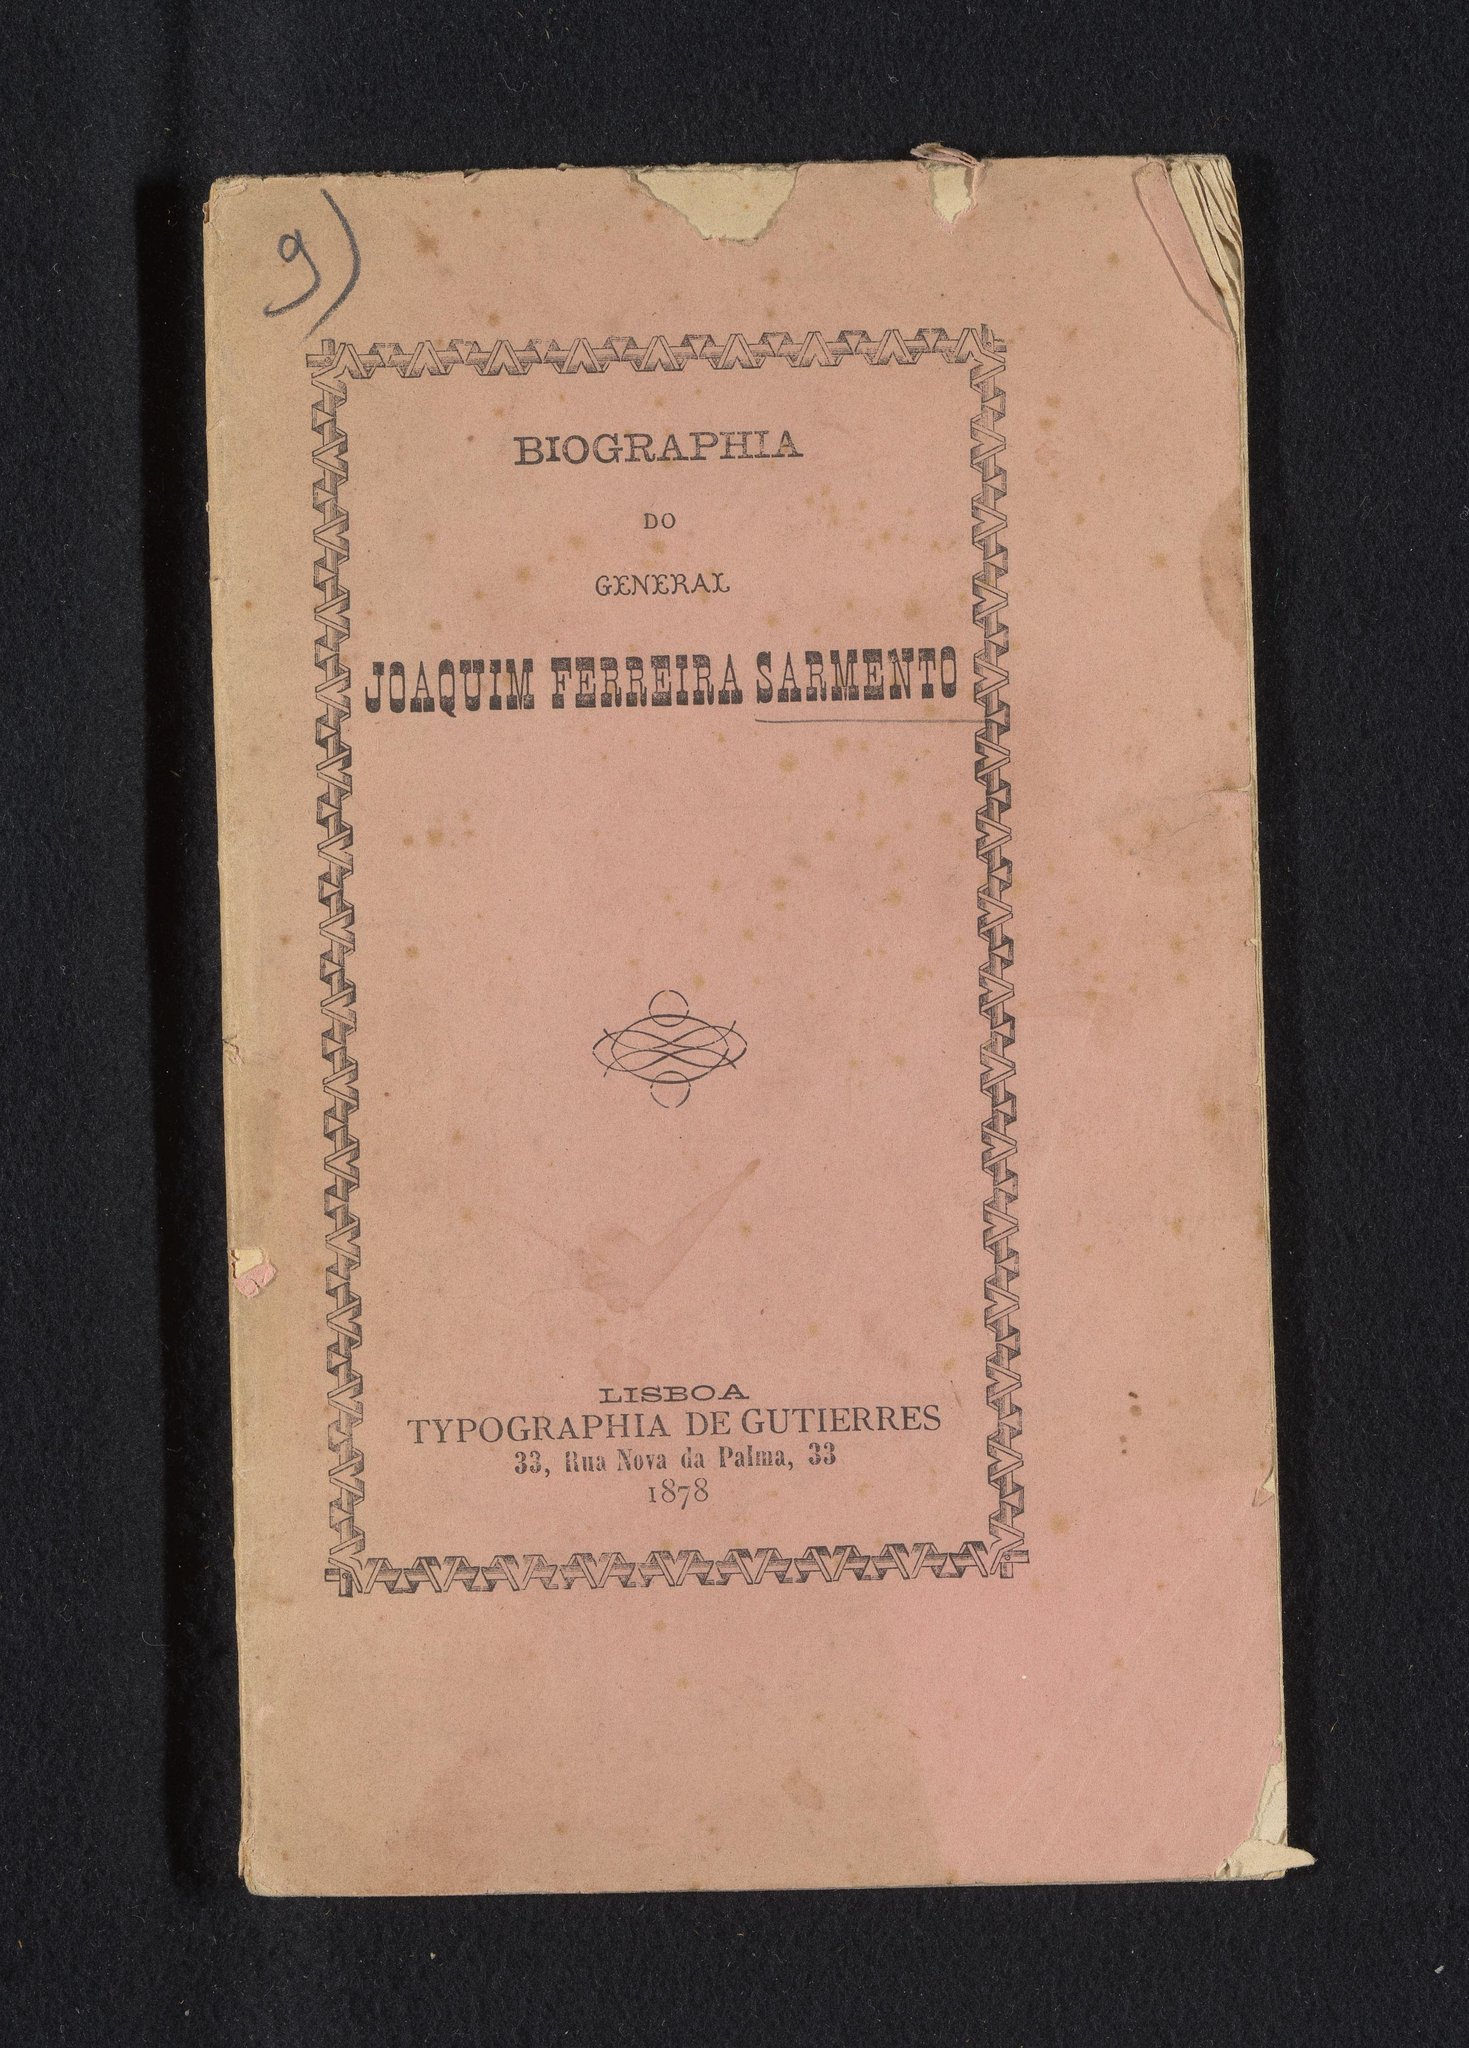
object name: book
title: Biographia do General Joaquim Ferreira Sarmanto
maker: melquiades sobral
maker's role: schrijver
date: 1878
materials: paper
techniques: albumen print, printing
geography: lisbon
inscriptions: inscription: ‘MAR 1992’